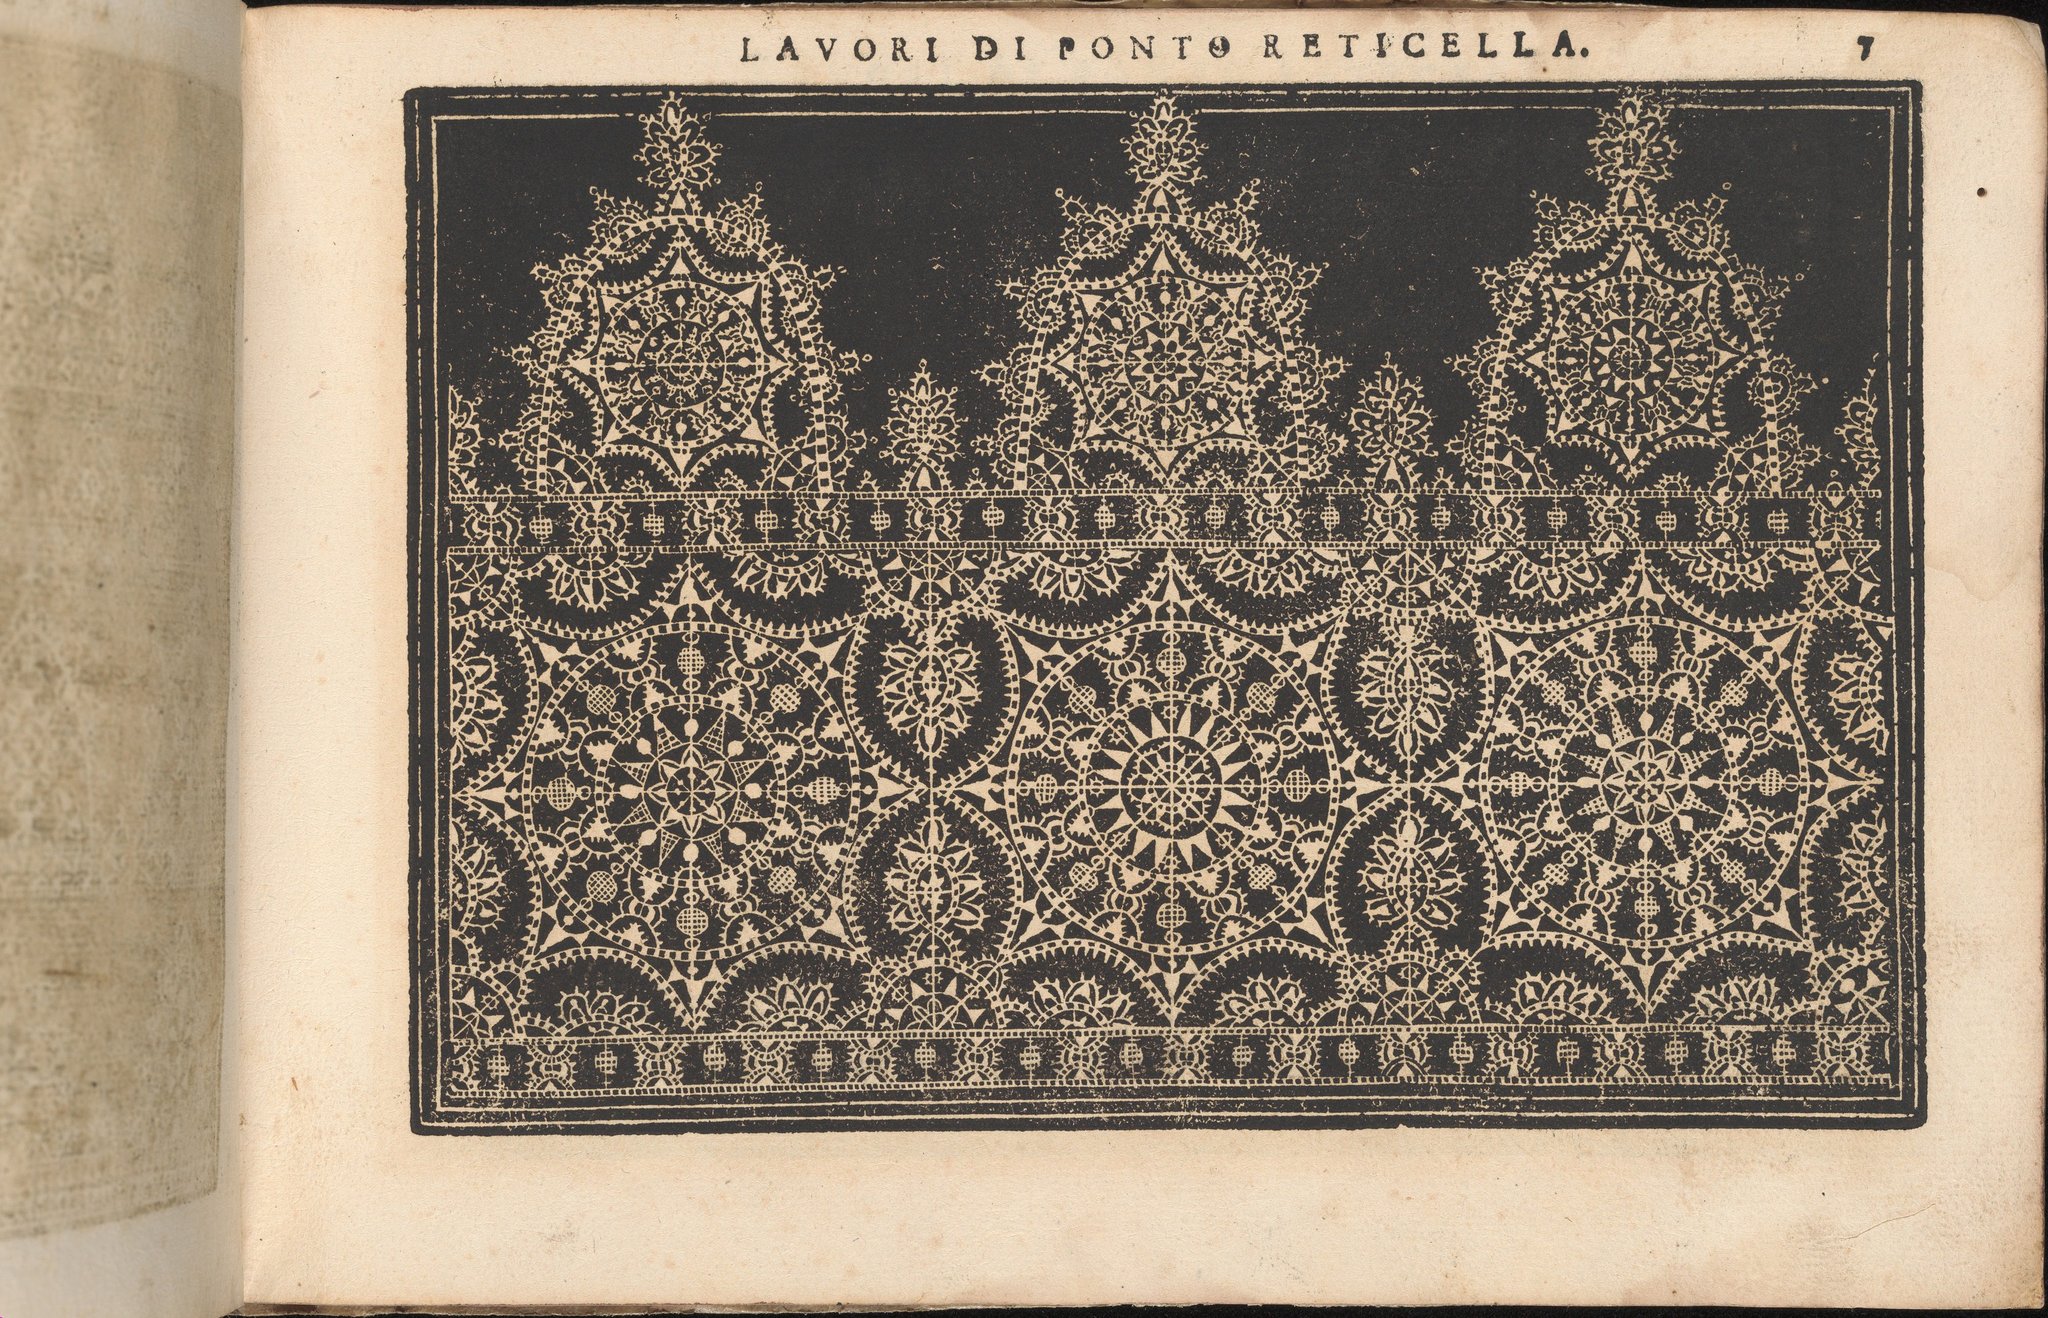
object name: book print ornament architecture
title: Teatro delle Nobili et Virtuose Donne..., page 9 (recto)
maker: isabella catanea parasole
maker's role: author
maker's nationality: italian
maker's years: 1565-1625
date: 1616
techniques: engraving, woodcut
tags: ornament